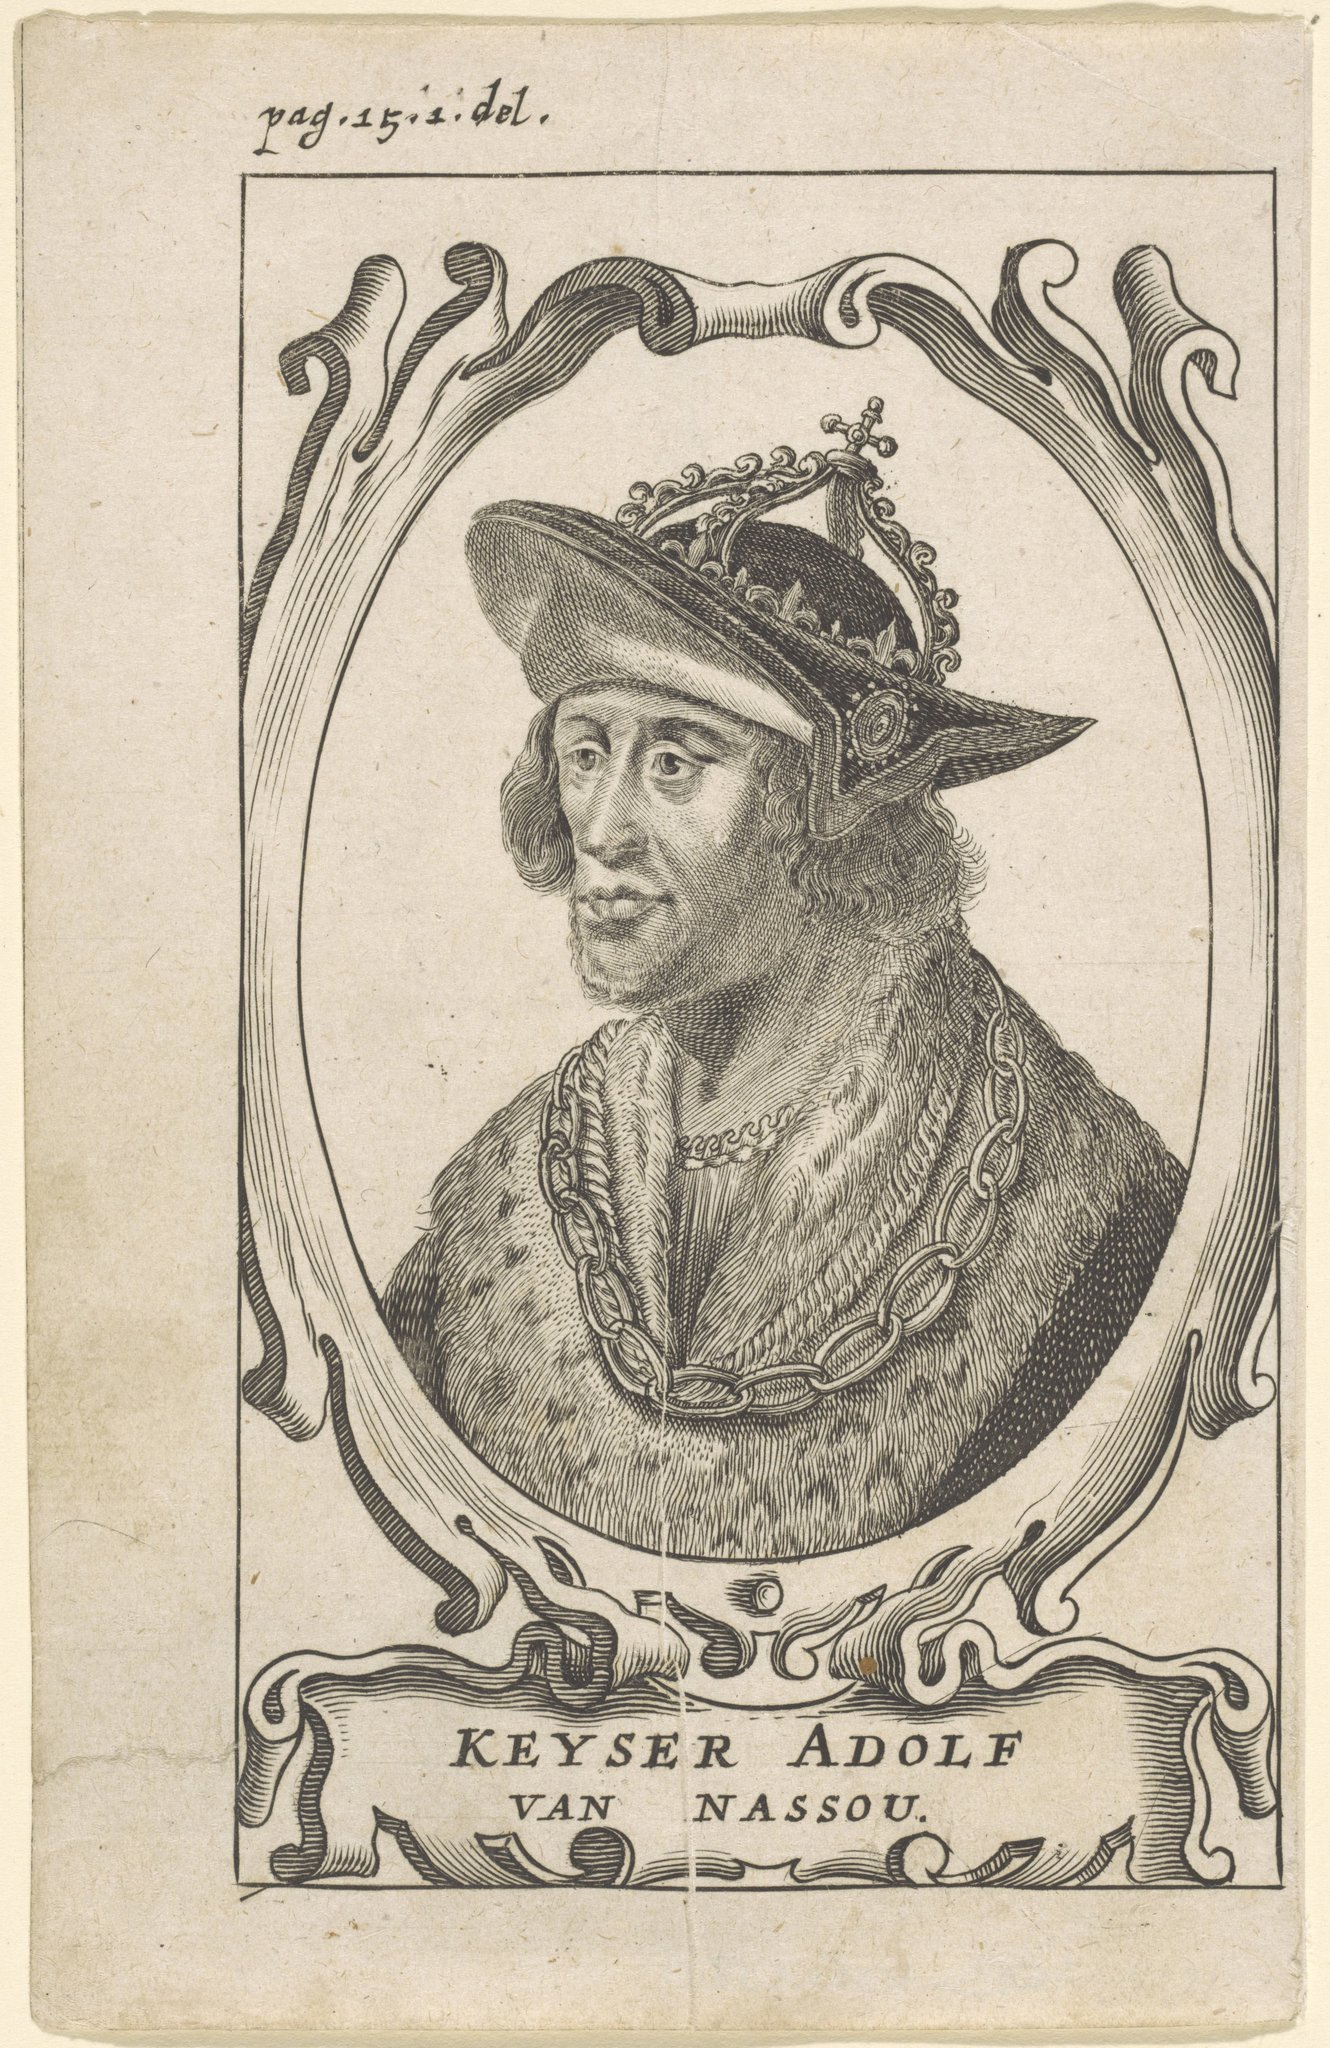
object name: print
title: Portret van Adolf, graaf van Nassau en Rooms-Duits koning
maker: Anonymous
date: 1600-1699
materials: paper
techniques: engraving, etching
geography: low countries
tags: gelnheim, koning, adolf (graaf van nassau en rooms-duits koning)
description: De hier vermelde titel verwijst naar de hoogst verkregen titel van de geportretteerde, niet per se naar de titel die de geportretteerde op deze voorstelling draagt.